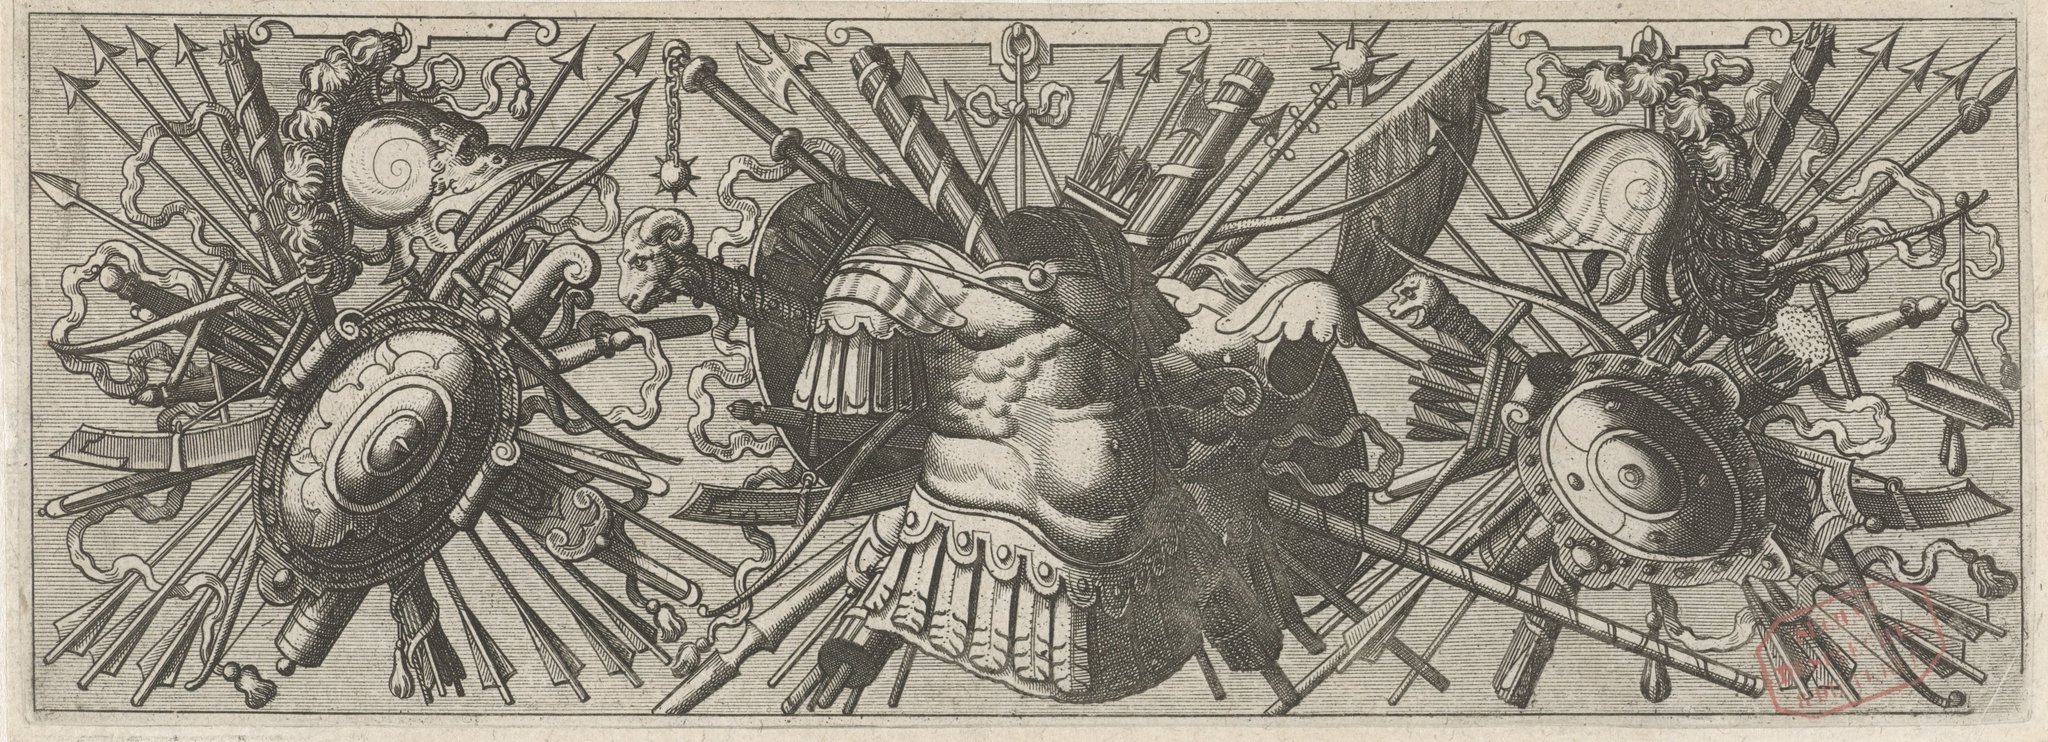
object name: ornament print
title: Panoplia sev armamentarium…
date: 1572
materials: paper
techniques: etching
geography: netherlands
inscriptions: collector's mark: Lugt 2275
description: Romeinse wapens waaronder houwers en pijlen, een stormram en een morgenster. Uit serie, bestaande uit een titelblad en 16 bladen.